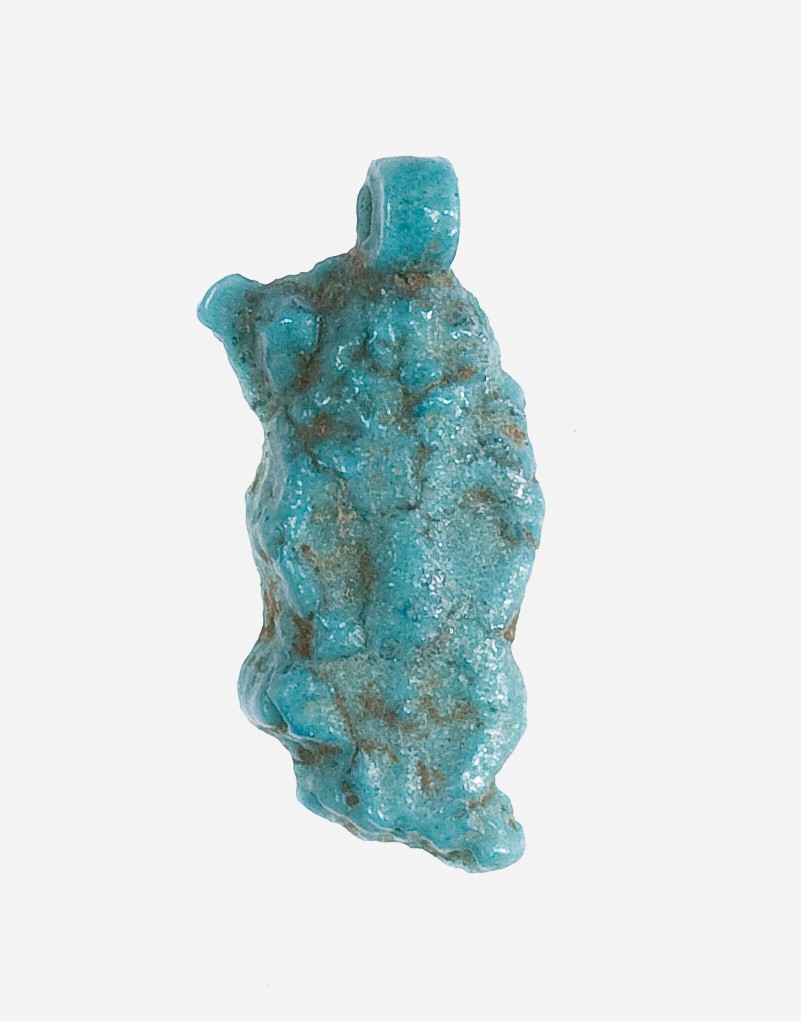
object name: amulet, be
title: Bes Amulet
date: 1390-1352 BCE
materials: faience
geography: egypt